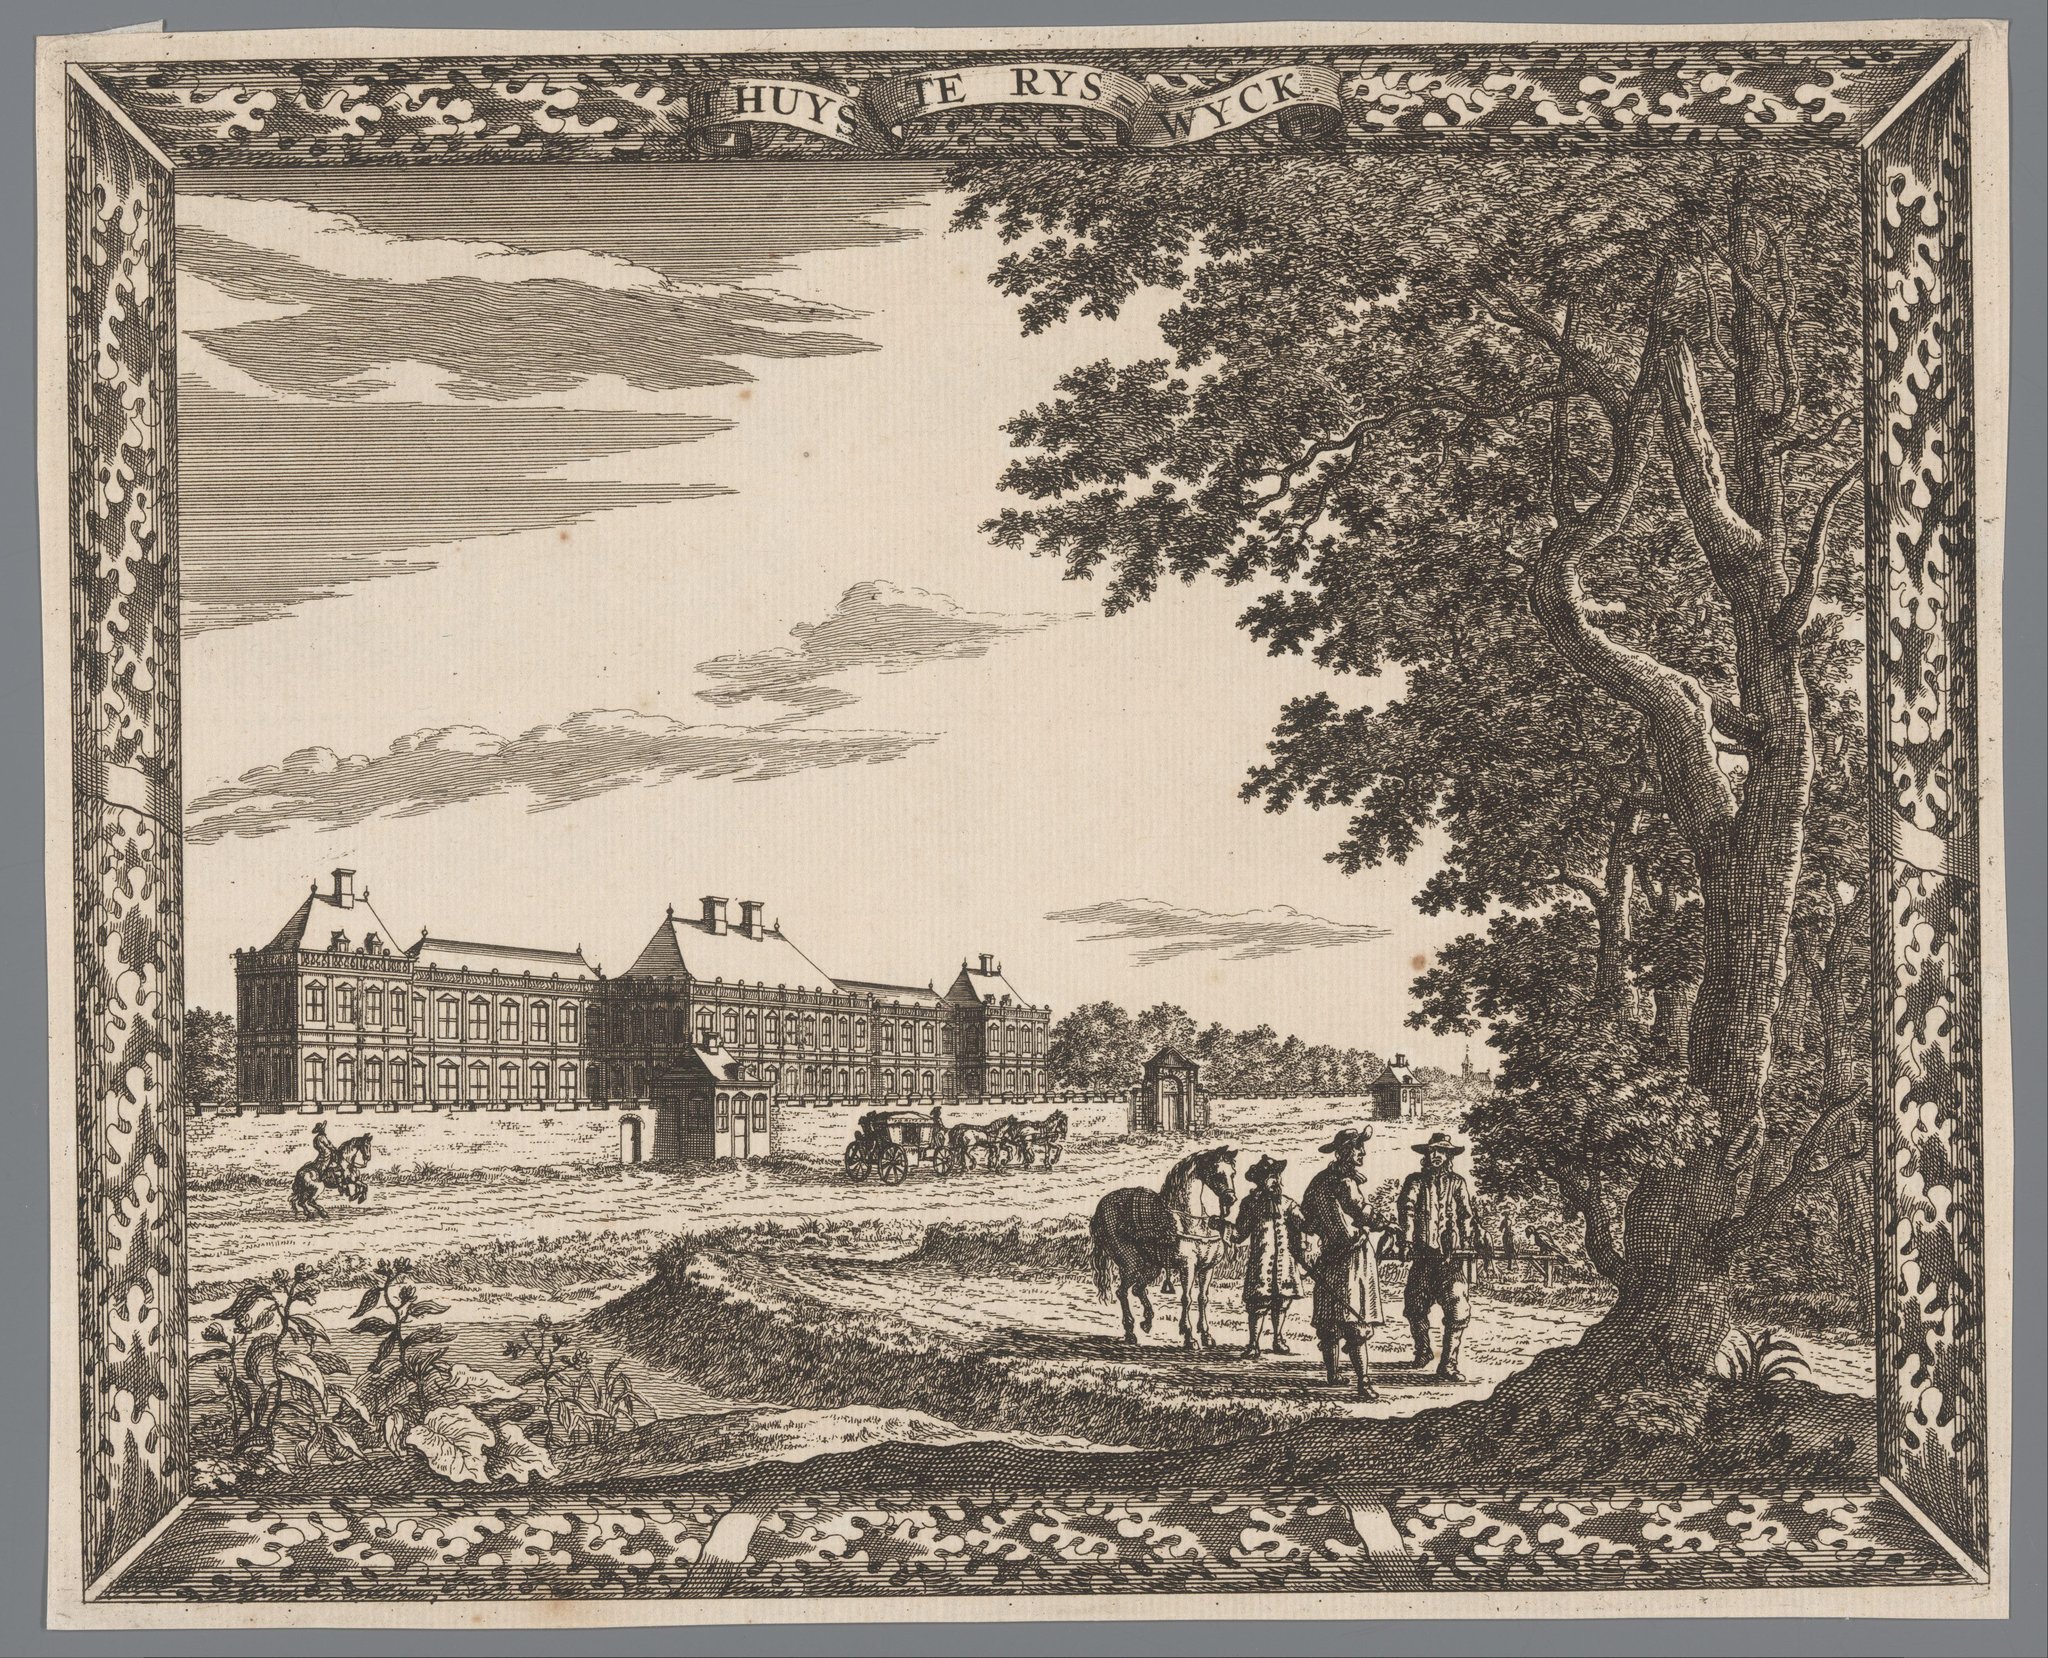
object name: print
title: t'Huys te Rys-Wyck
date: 1681-1682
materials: paper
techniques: etching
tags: castle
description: Deze prent is oorspronkelijk uitgegeven als onderdeel van de rand van de zogenaamde figuratieve kaart van Den Haag uit 1681-1682 (zie RP-P-AO-12-9D). De rand bestond uit een gezicht op de stad en veertien kleinere gezichten in en om Den Haag.